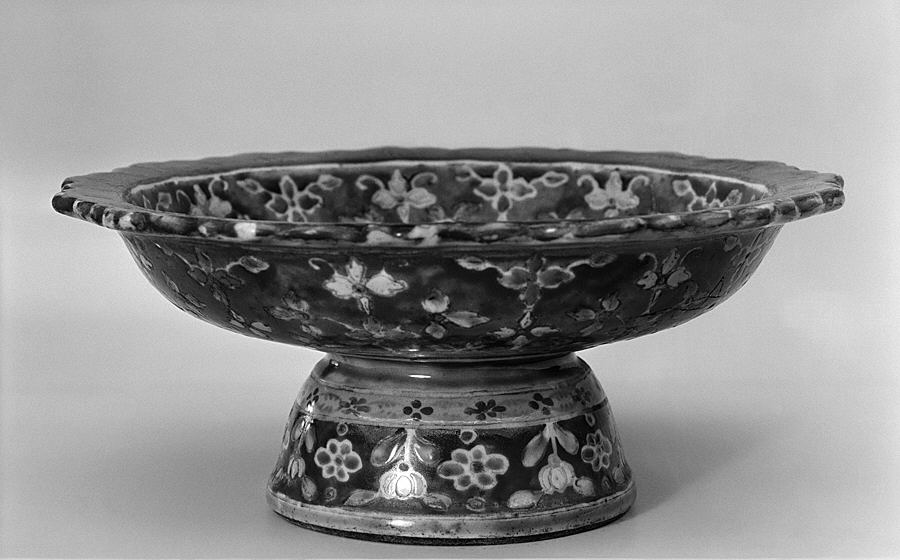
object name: footed dish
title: Footed dish with floral pattern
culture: chinese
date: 1801-1900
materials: enamel, porcelain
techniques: overglaze, painting, polychrome